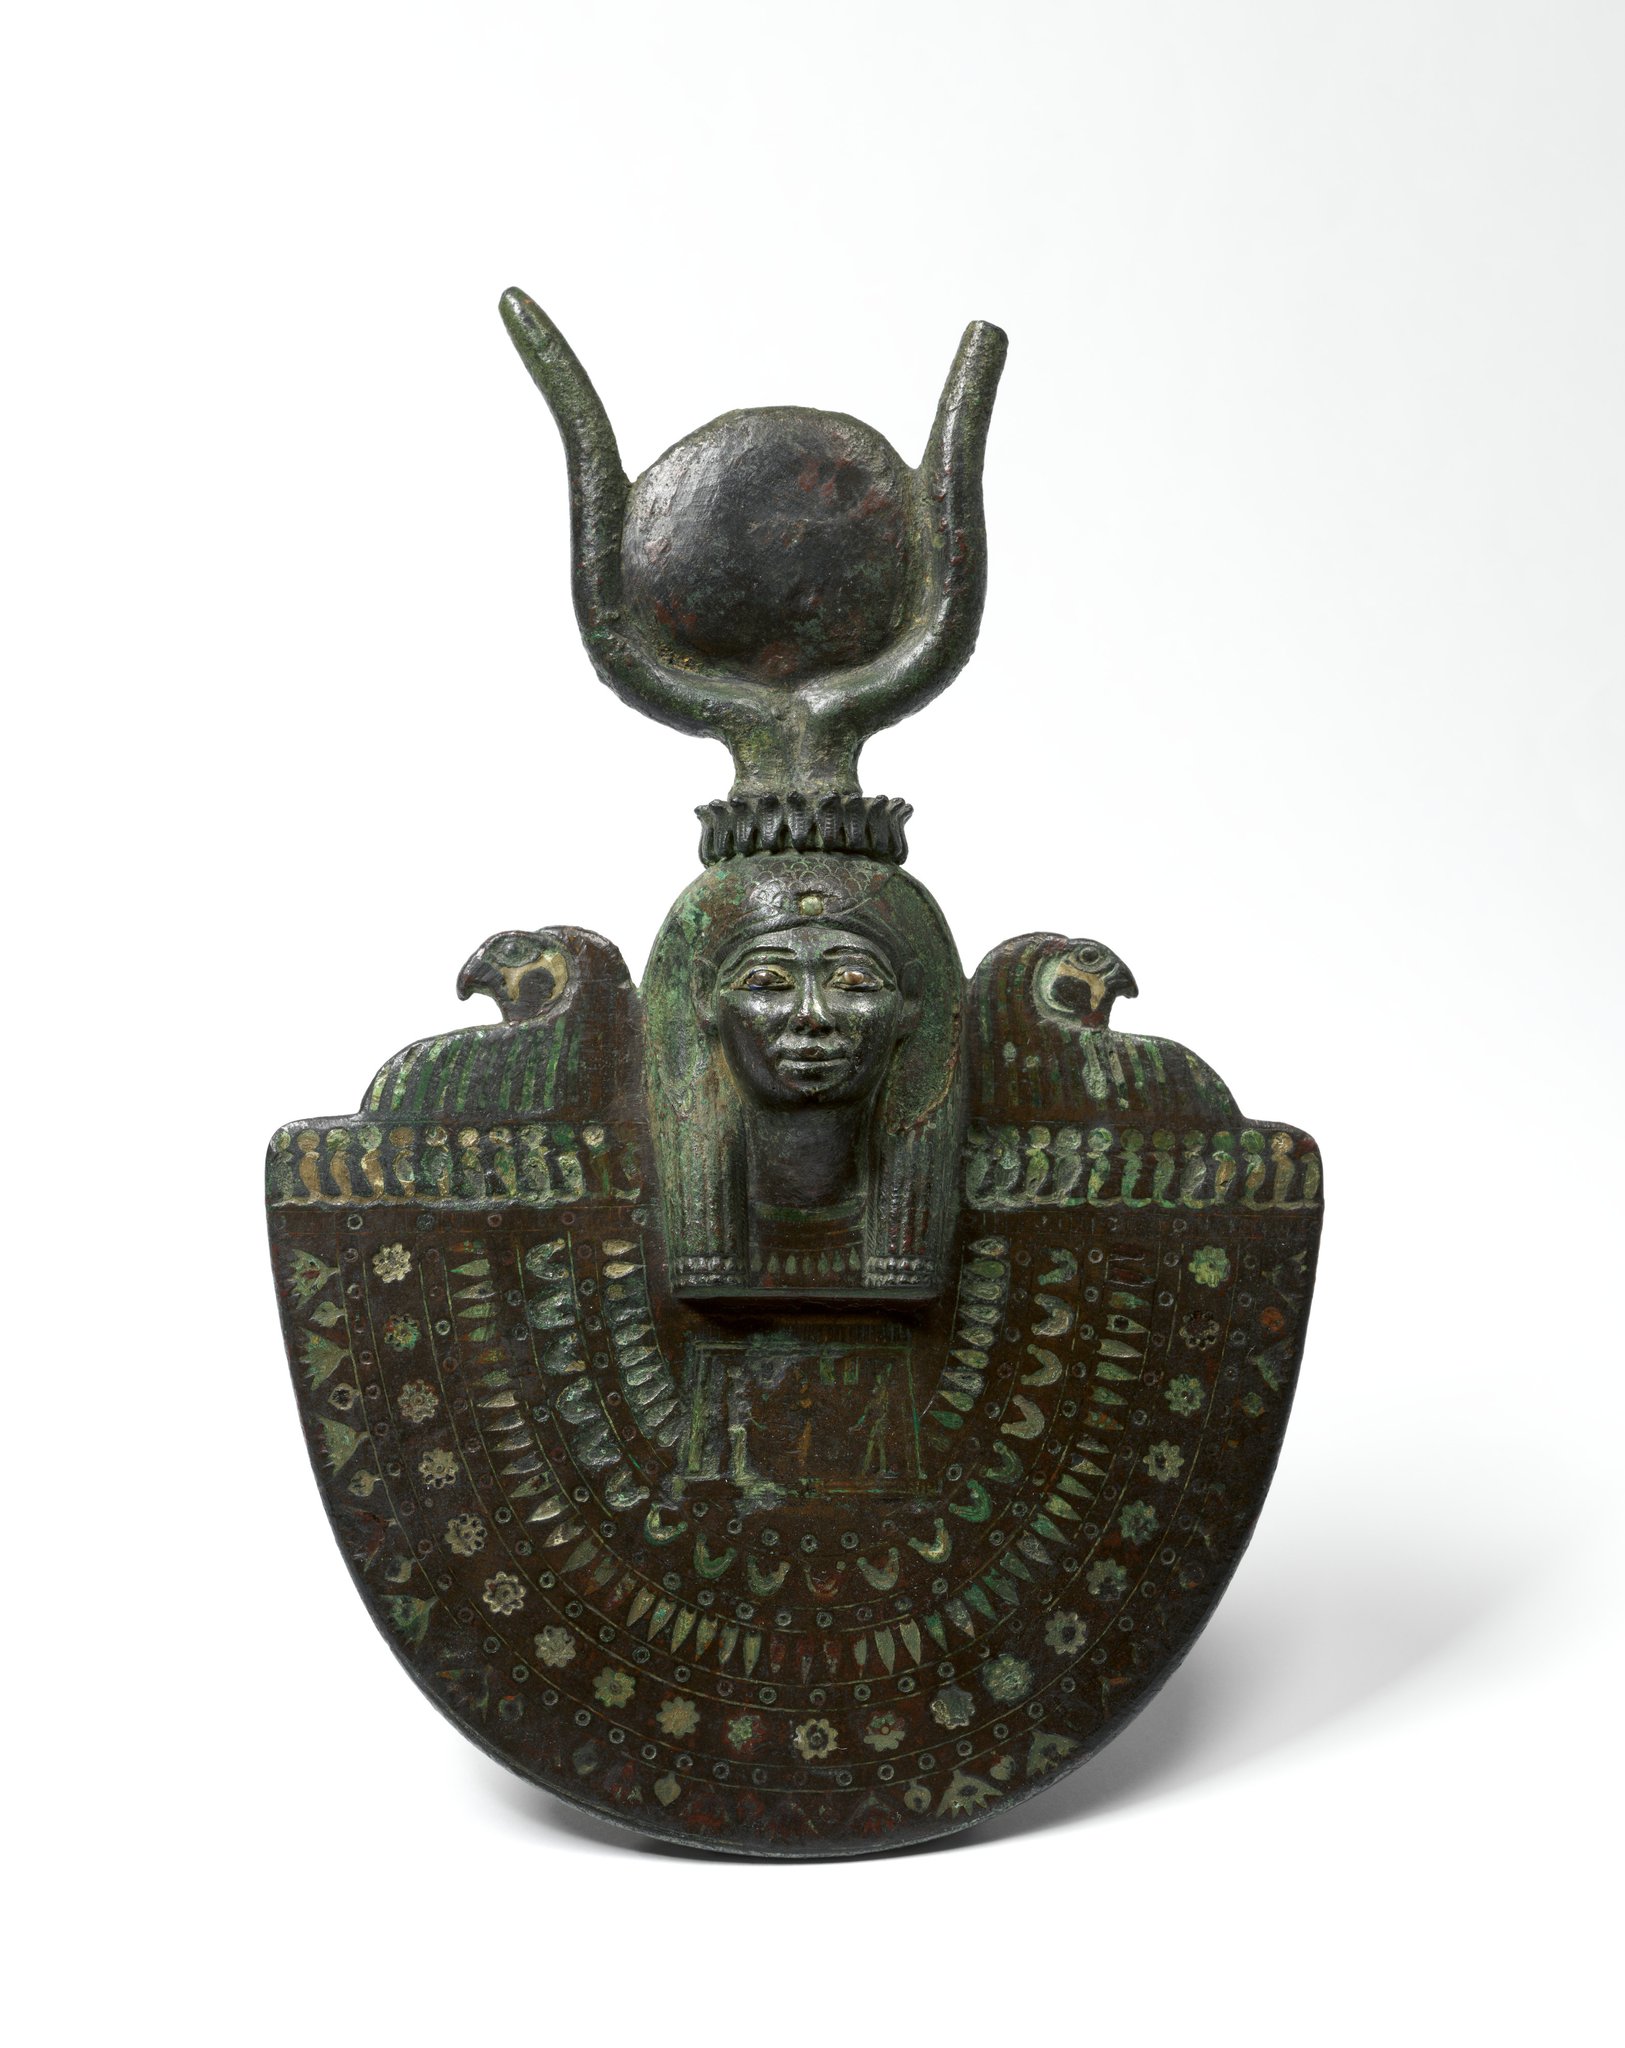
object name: amulet, aegis of isi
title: An aegis of Isis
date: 664-343 BCE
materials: bronze, copper alloy, glass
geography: egypt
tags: isis